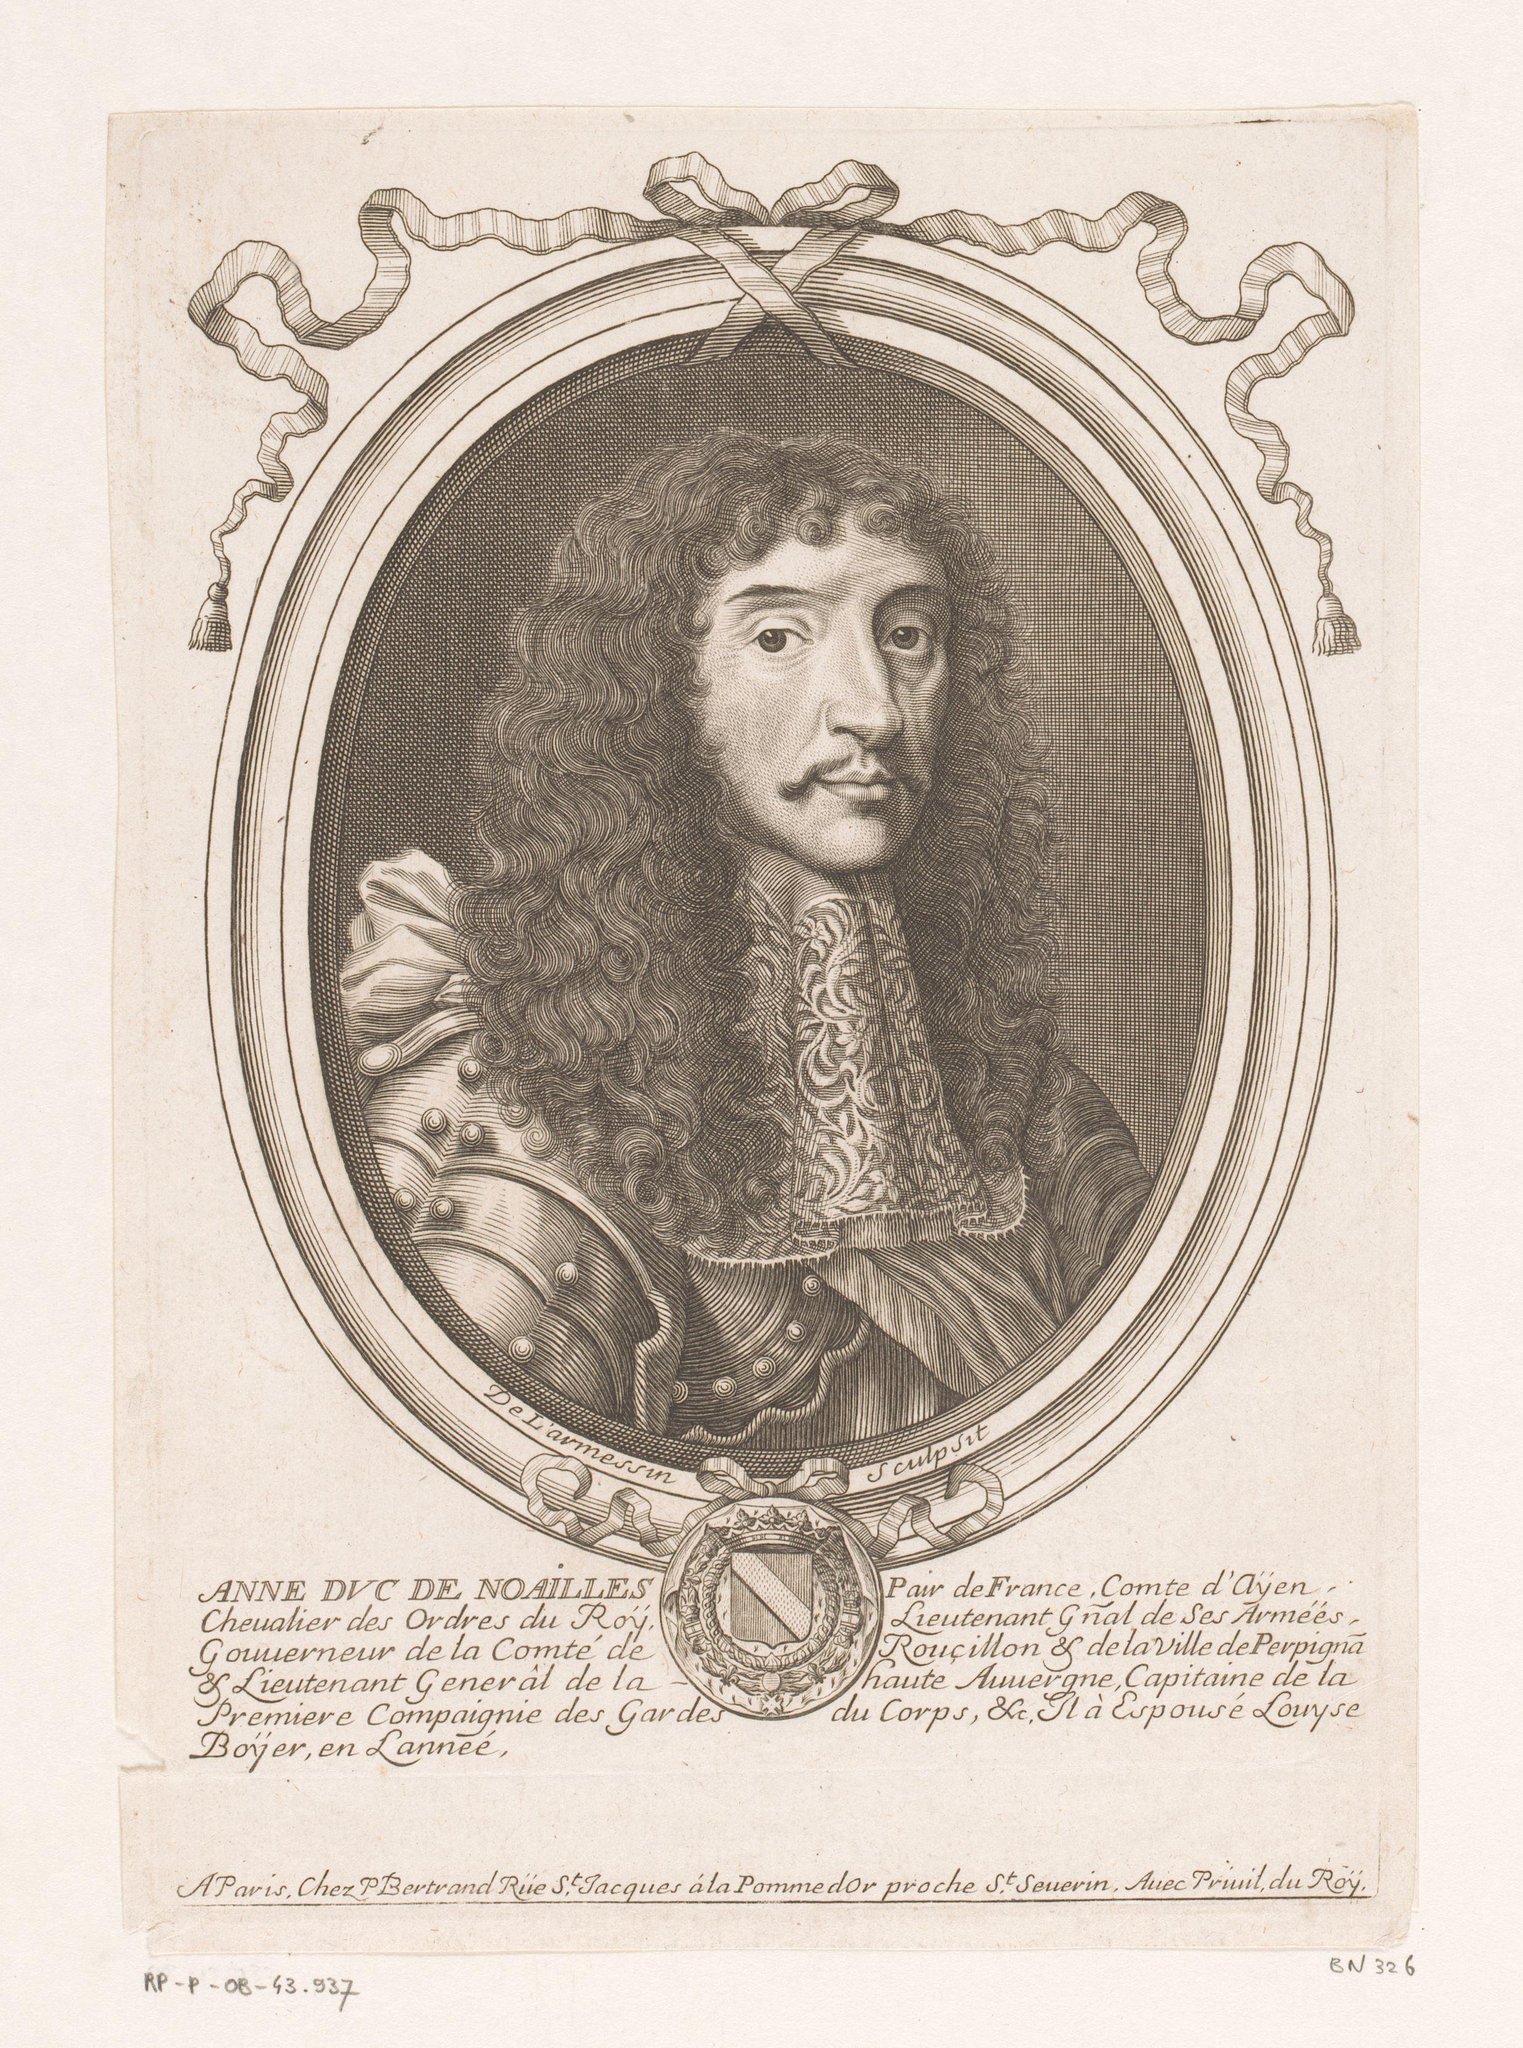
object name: print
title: Portretten van prominente figuren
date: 1642-1678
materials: paper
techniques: engraving, etching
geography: france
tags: historical persons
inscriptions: collector's mark: Lugt 2228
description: Maakt deel uit van een grootschalige serie met portretten van prominente figuren. Binnen de serie bevindt zich een sectie getiteld 'Les Augustes Représentations De tous les Roys De France depuis Pharamond Iusqu'à Louys XIIII'. De serie werd respectievelijk uitgegeven door Pierre Bertrand, door zijn weduwe en door De Larmessin zelf.